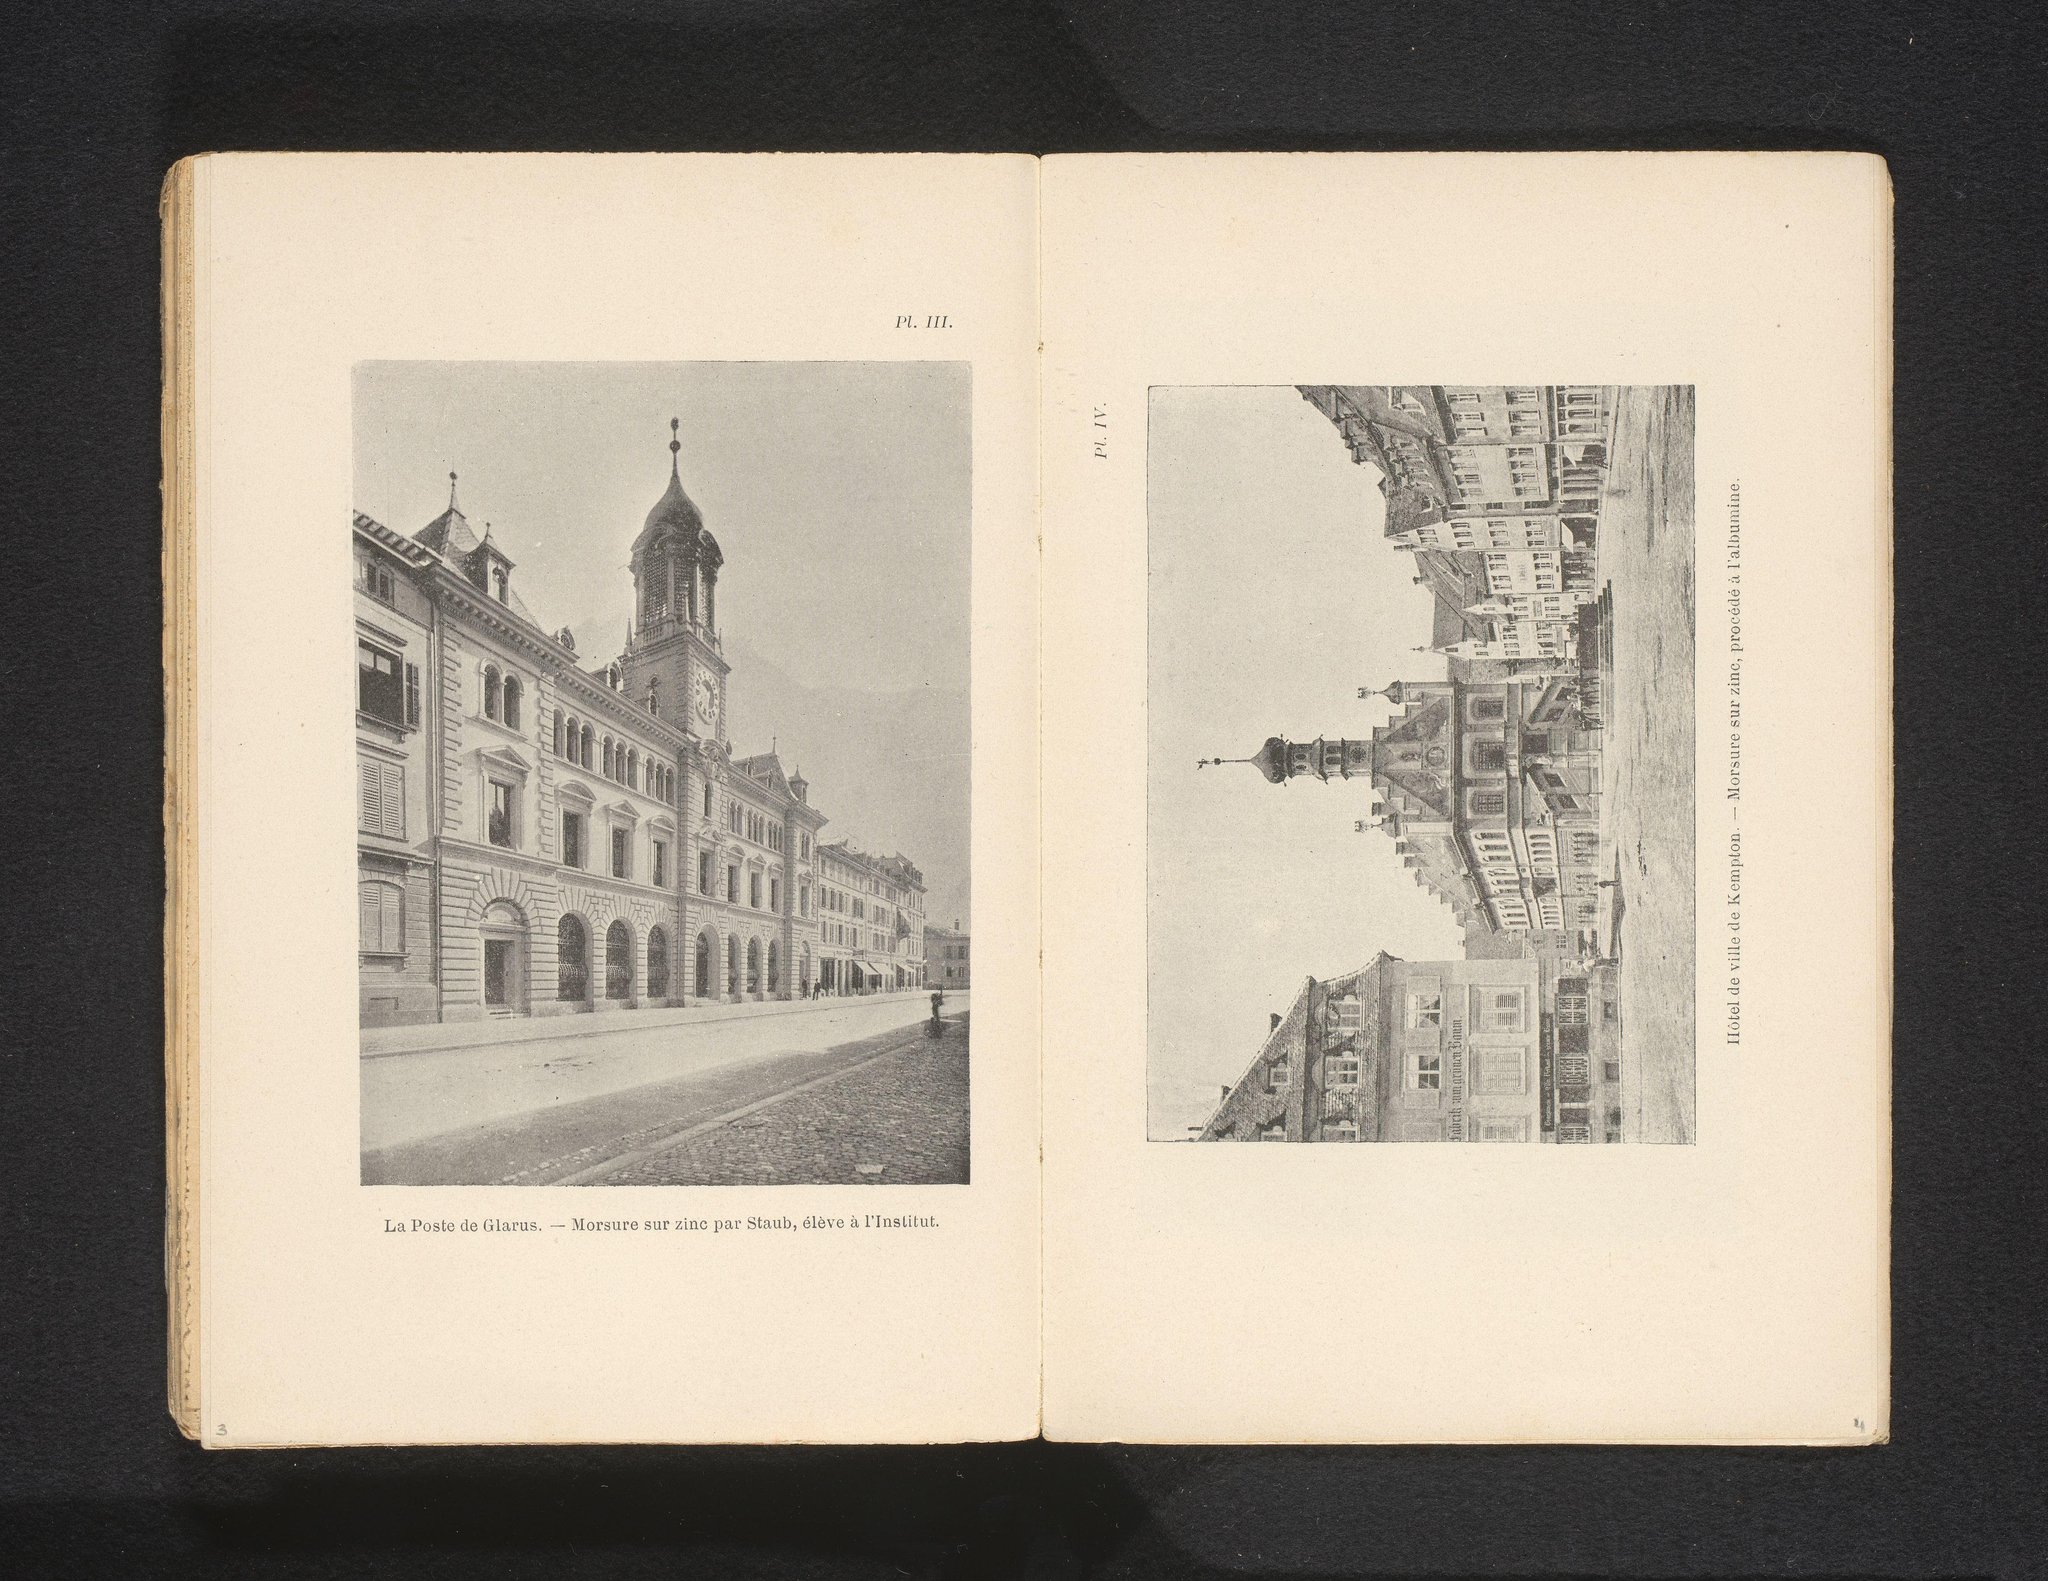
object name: page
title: La Poste de Glarus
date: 1888-1898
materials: paper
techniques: autotype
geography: glarus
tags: post-office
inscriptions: number: ‘Pl. III.’, inscription: ‘élève à l'Institut’